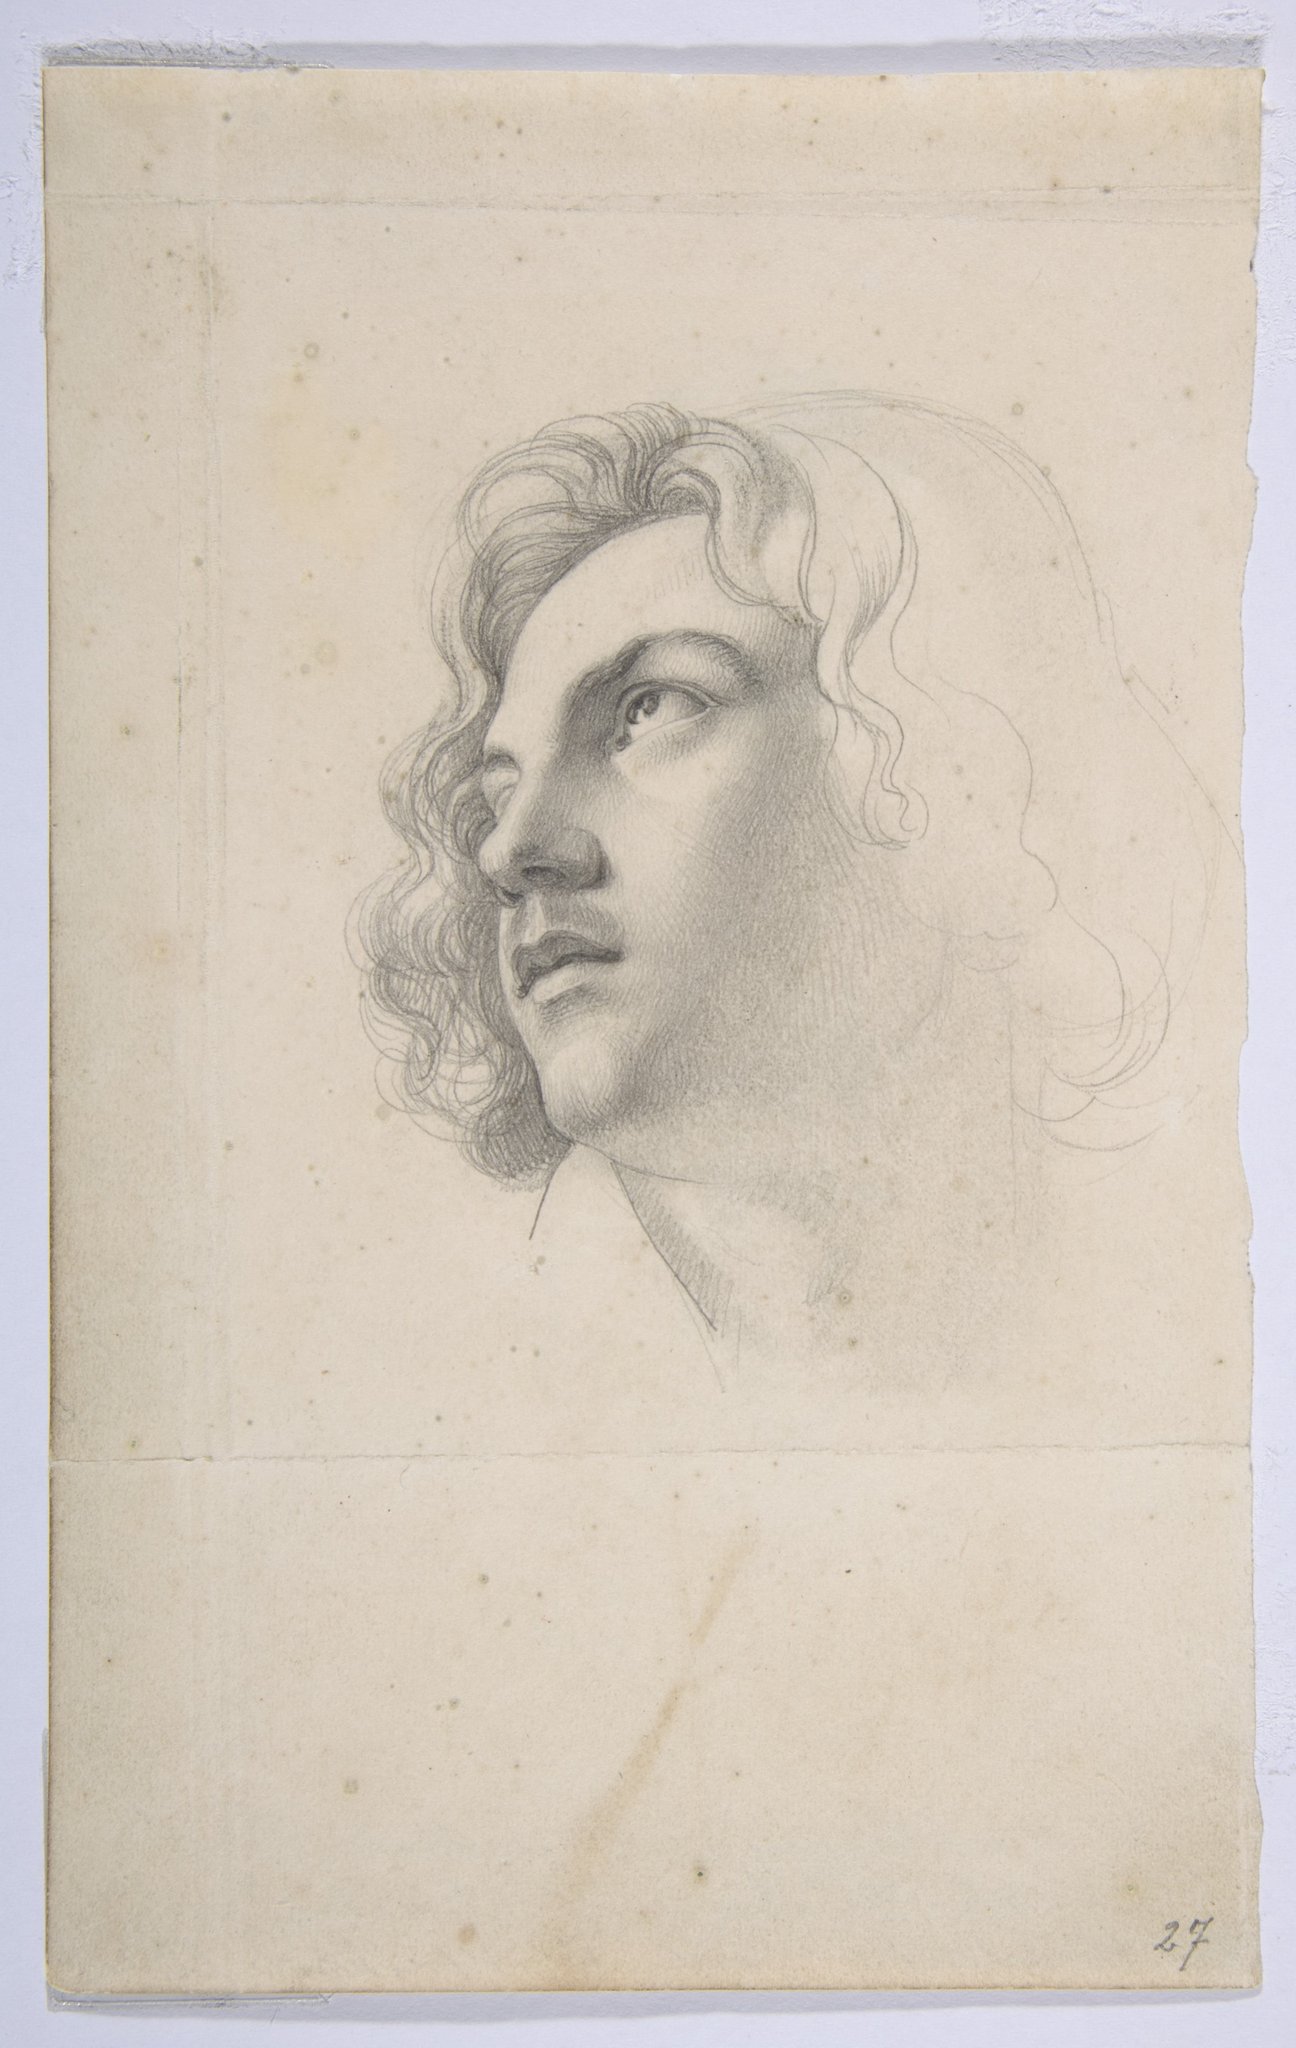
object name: drawing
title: Portrait of Alfred Rethel, looking up; verso: Studies of two heads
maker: heinrich karl anton mücke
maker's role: artist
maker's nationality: german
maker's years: 1806-1891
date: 1801-1900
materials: graphite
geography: germany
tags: men,profiles